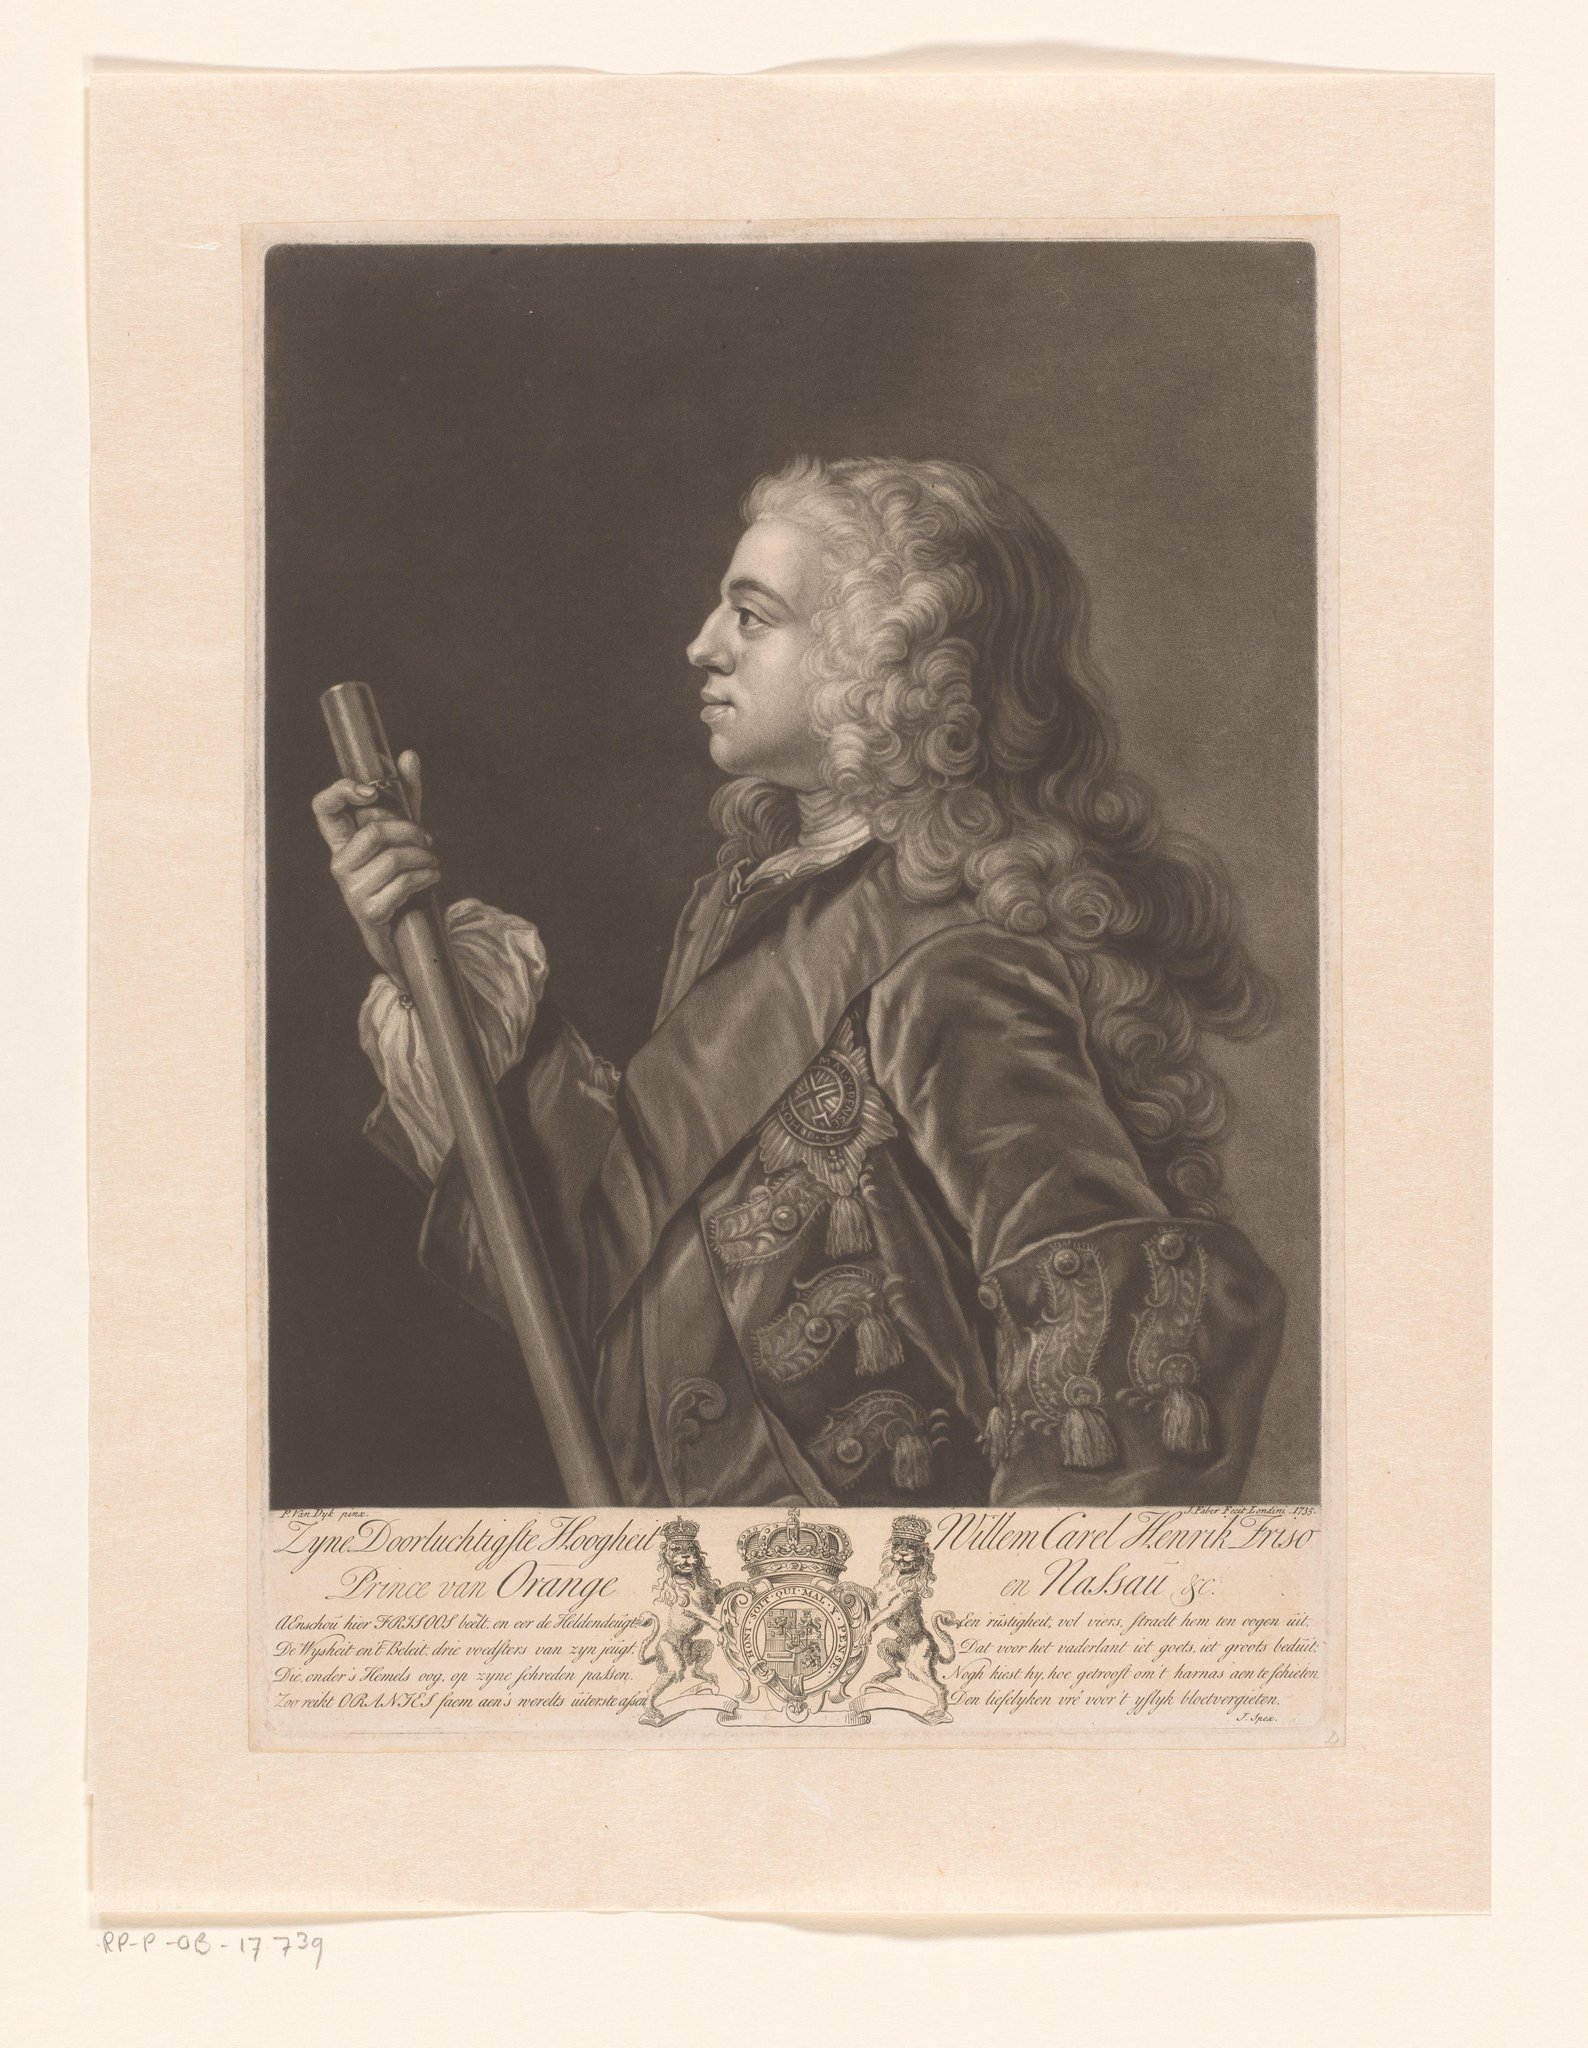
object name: print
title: Portret van Willem IV, stadhouder en prins van Oranje-Nassau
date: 1735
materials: paper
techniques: etching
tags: the hague, willem iv (prins van oranje-nassau), historical persons, ruler, sovereign, baton of general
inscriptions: collector's mark: Lugt 240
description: Tekst in het Nederlands in de ondermarge.